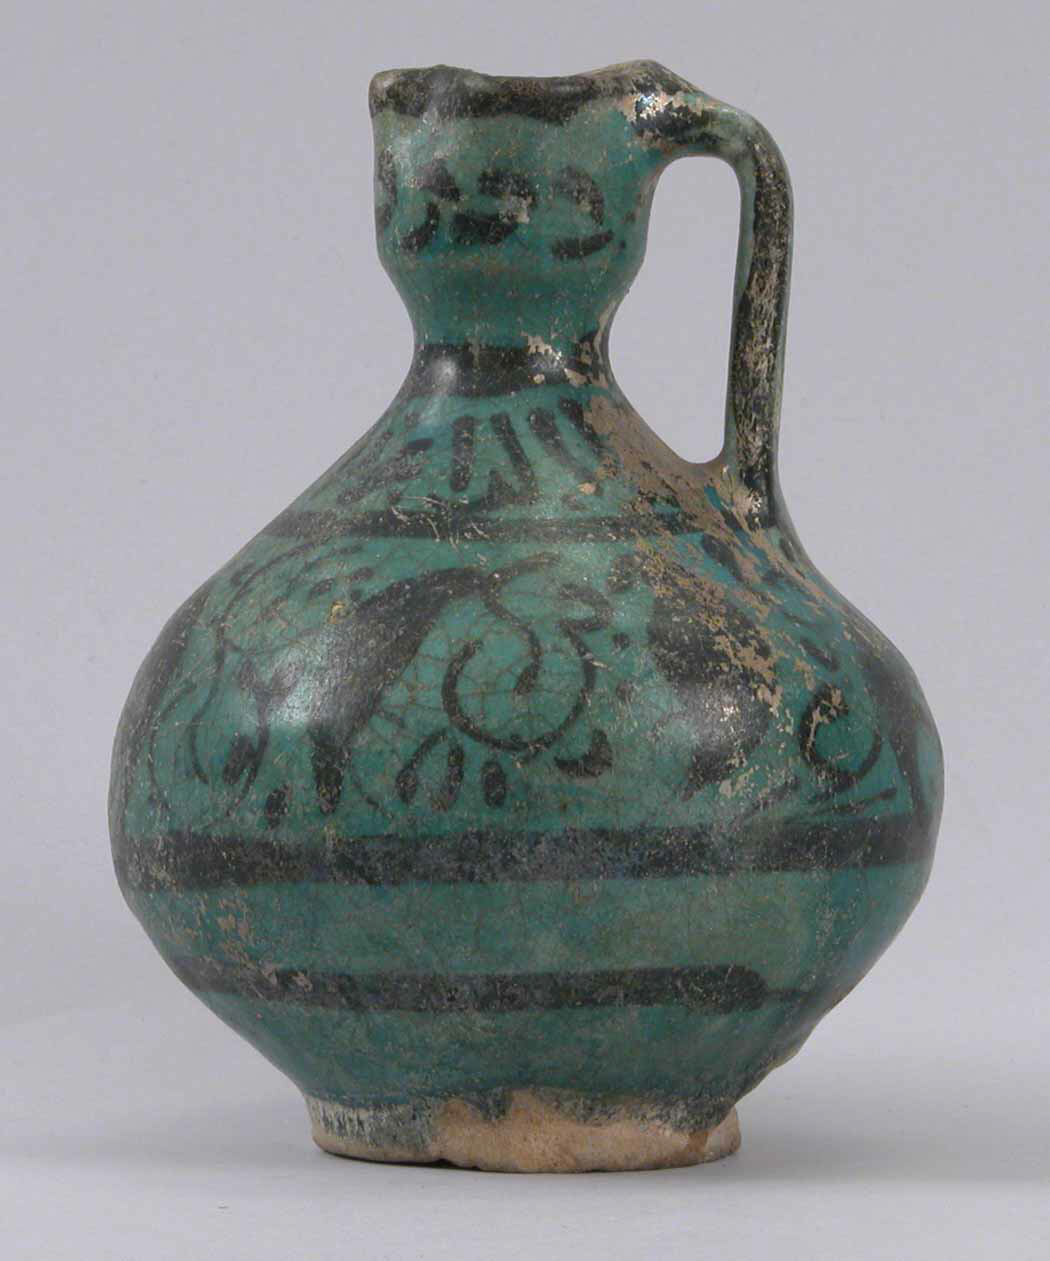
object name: ewer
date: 1101-1300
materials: stonepaste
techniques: painting, underglaze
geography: syria